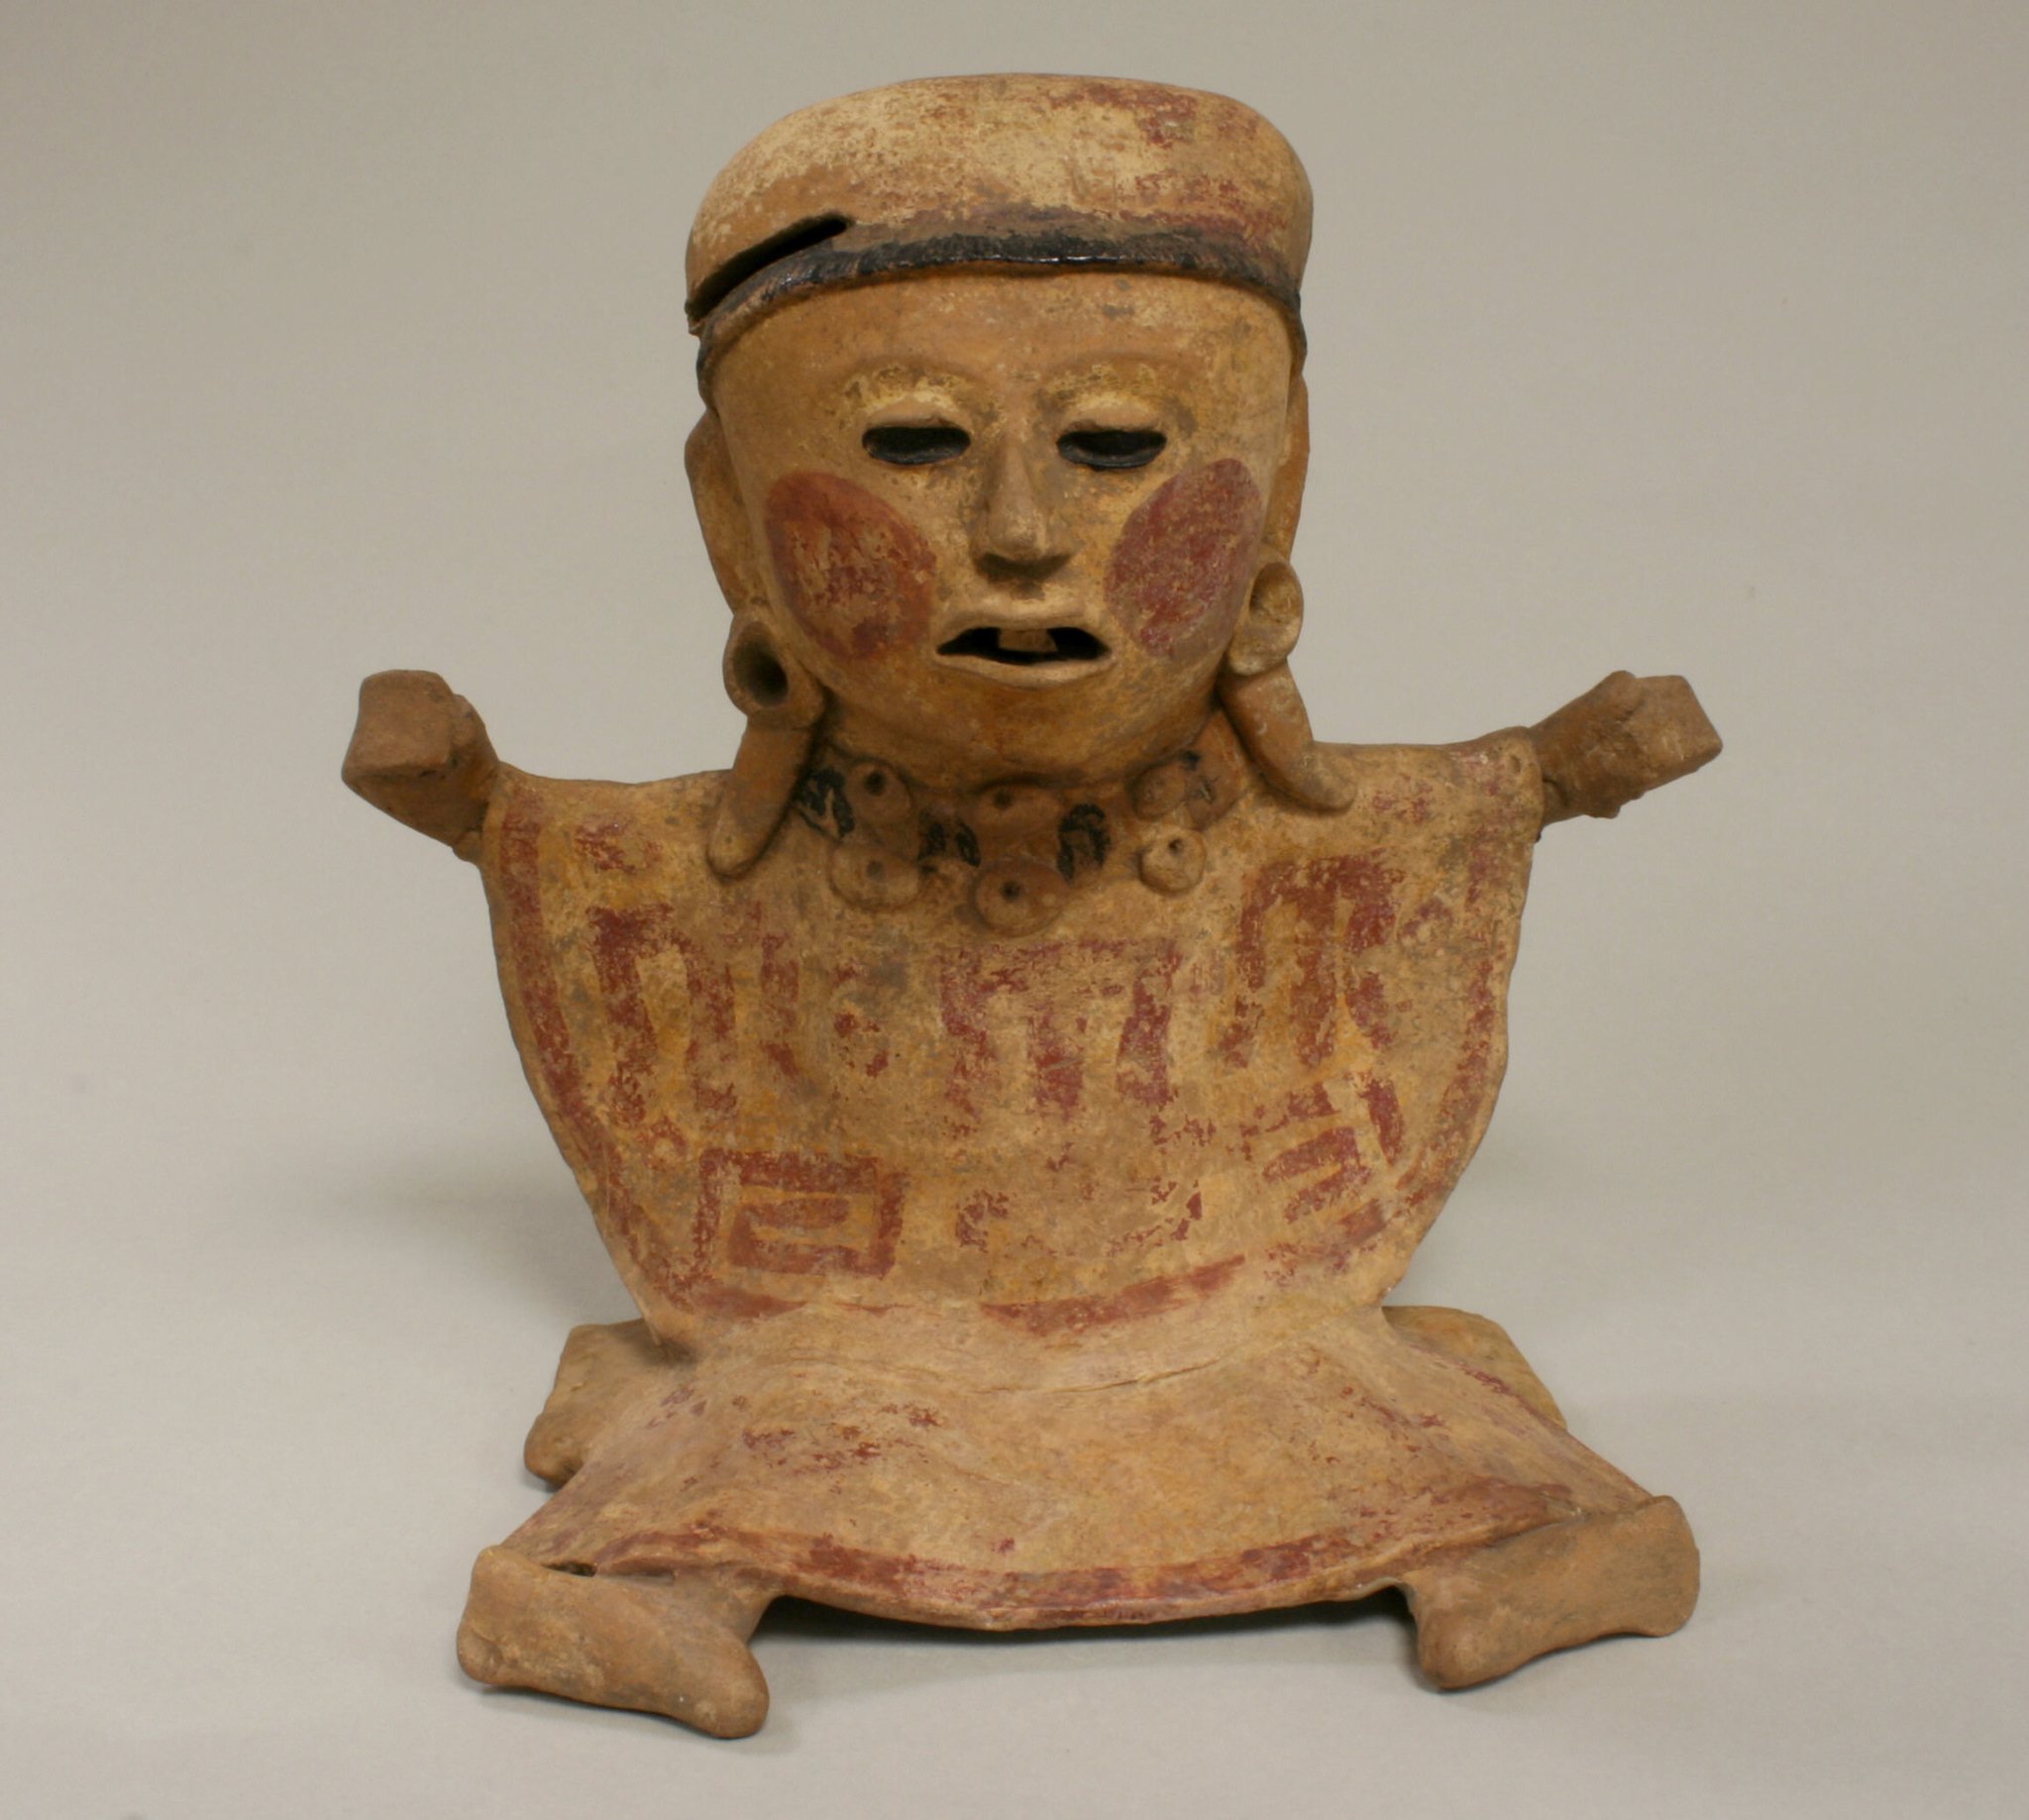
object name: whistle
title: Seated female figure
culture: veracruz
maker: remojadas artist(s)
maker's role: artist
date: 600-1000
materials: ceramic, paint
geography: mexico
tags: women